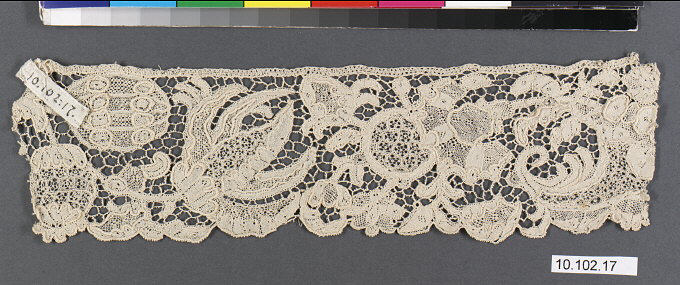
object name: fragment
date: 1701-1800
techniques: lace